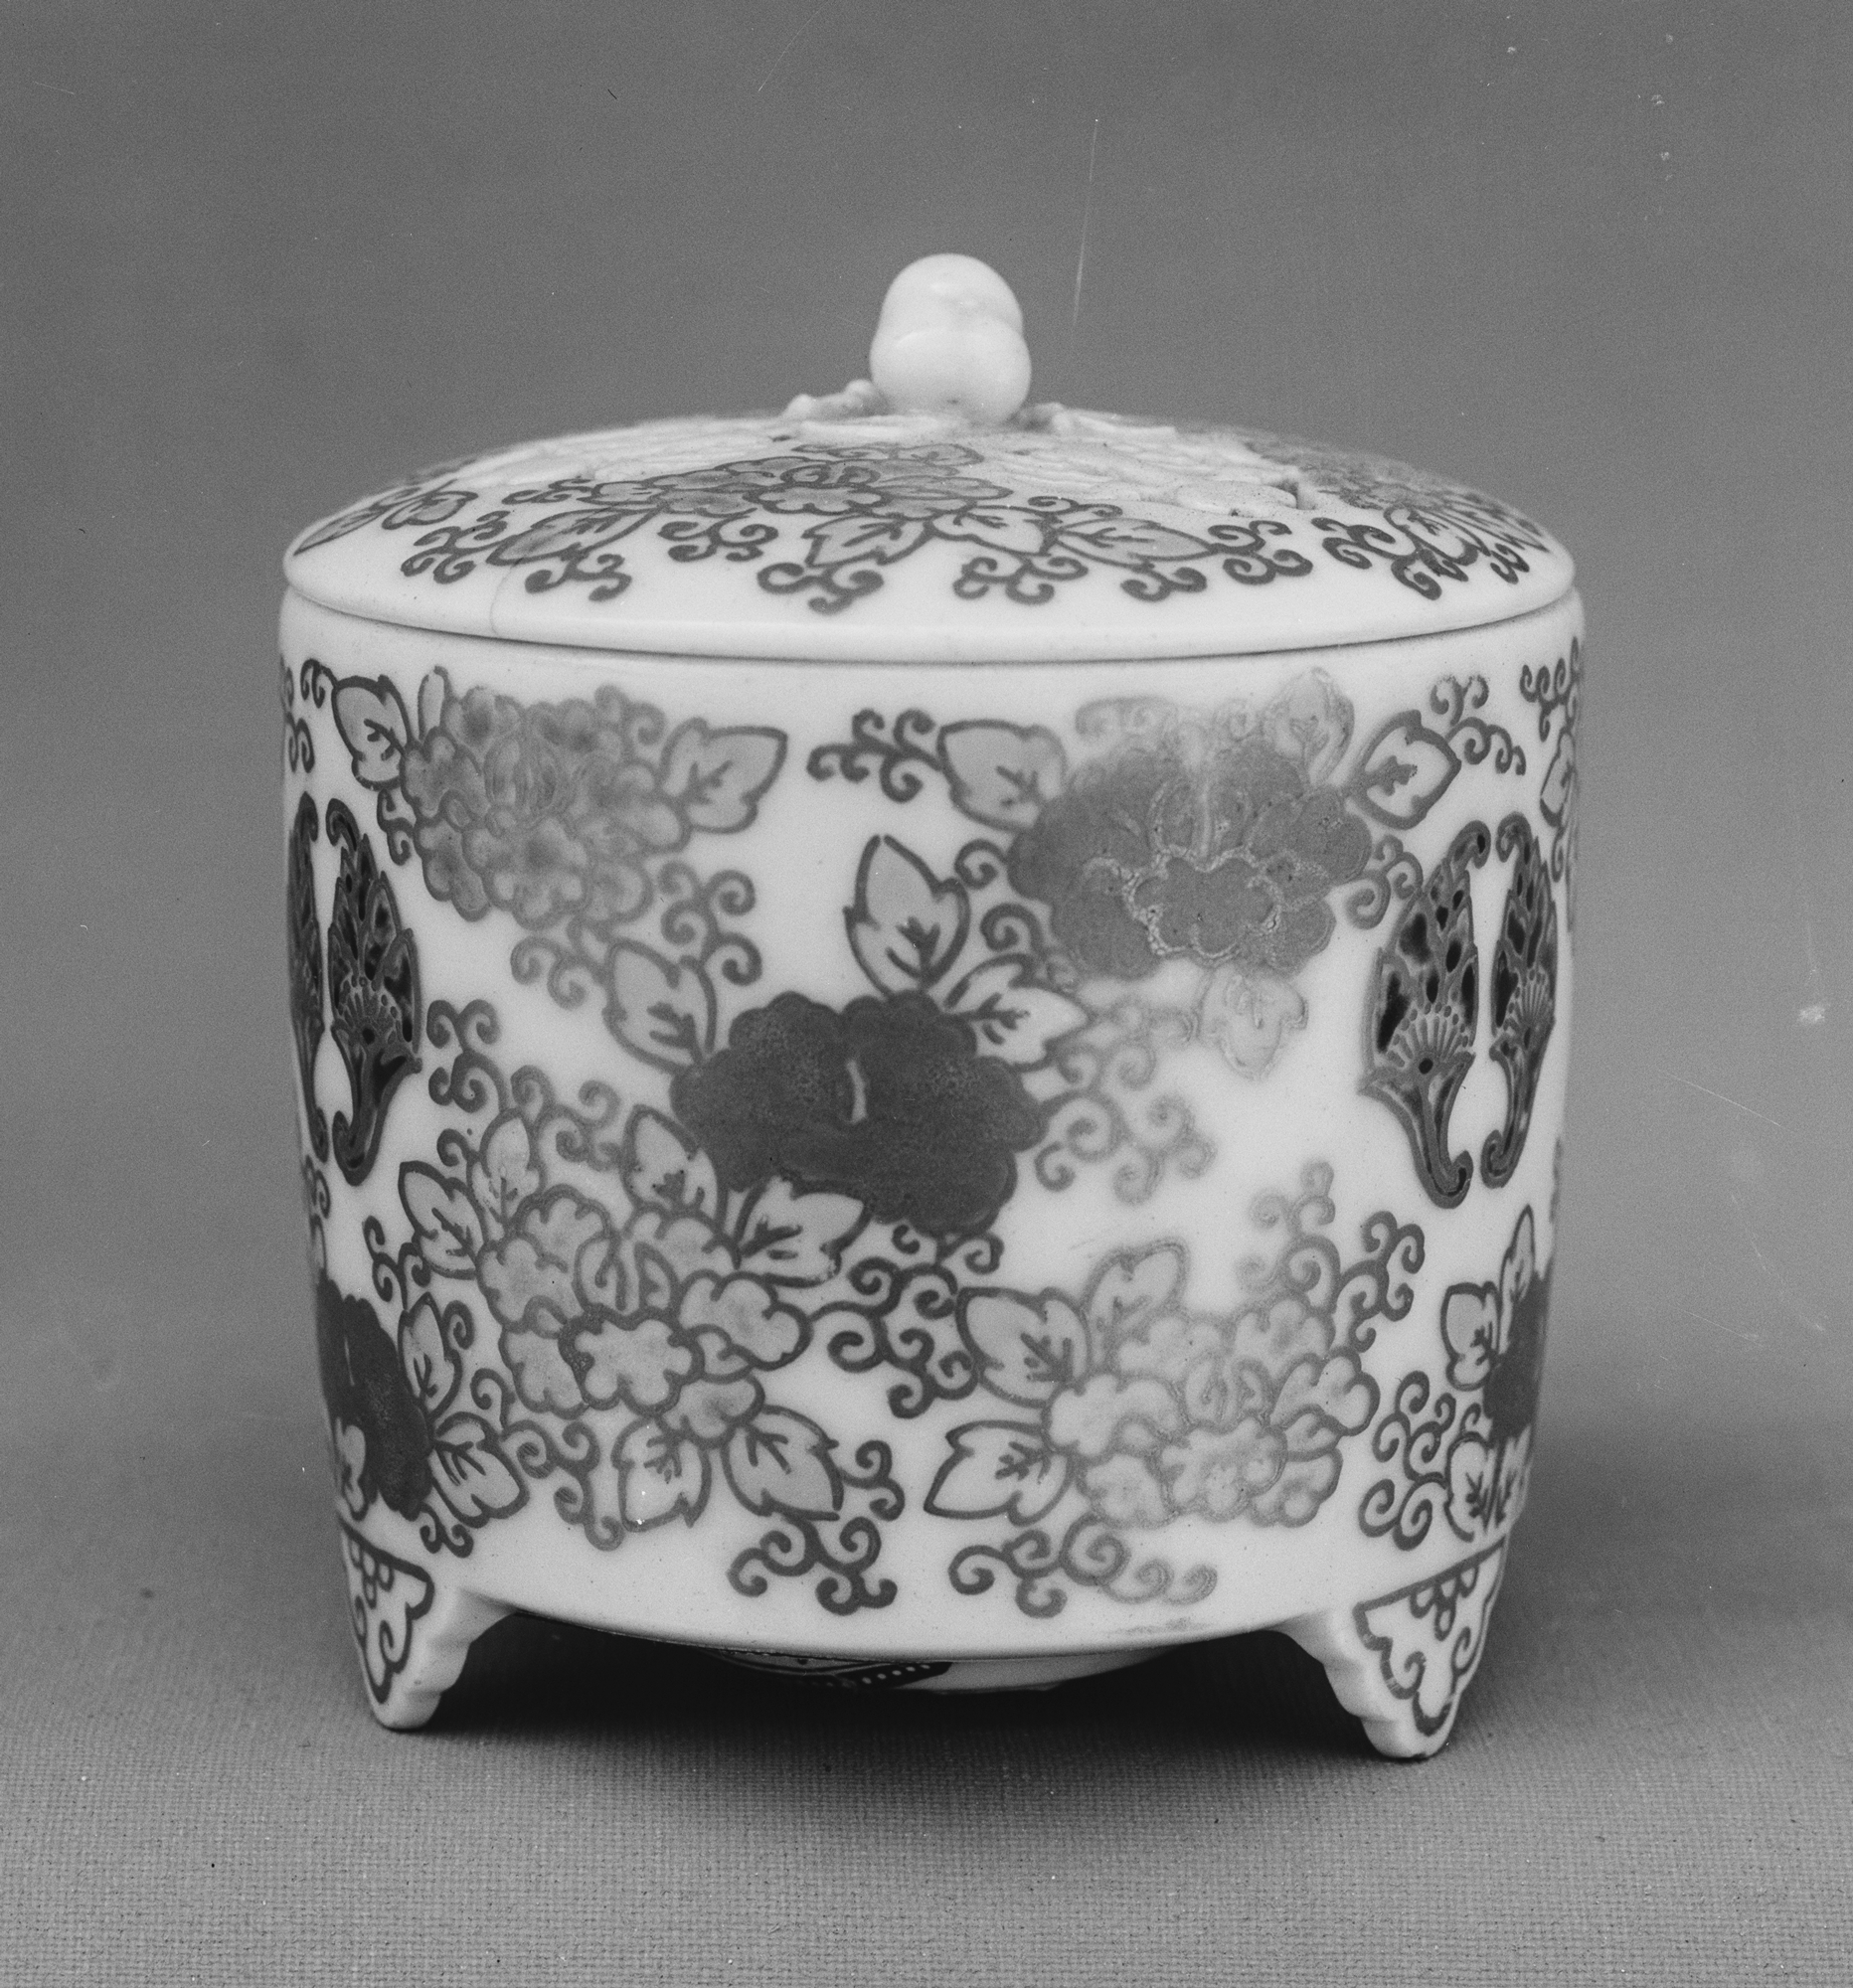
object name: incense burner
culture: japanese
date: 1760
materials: enamel, gold, porcelain